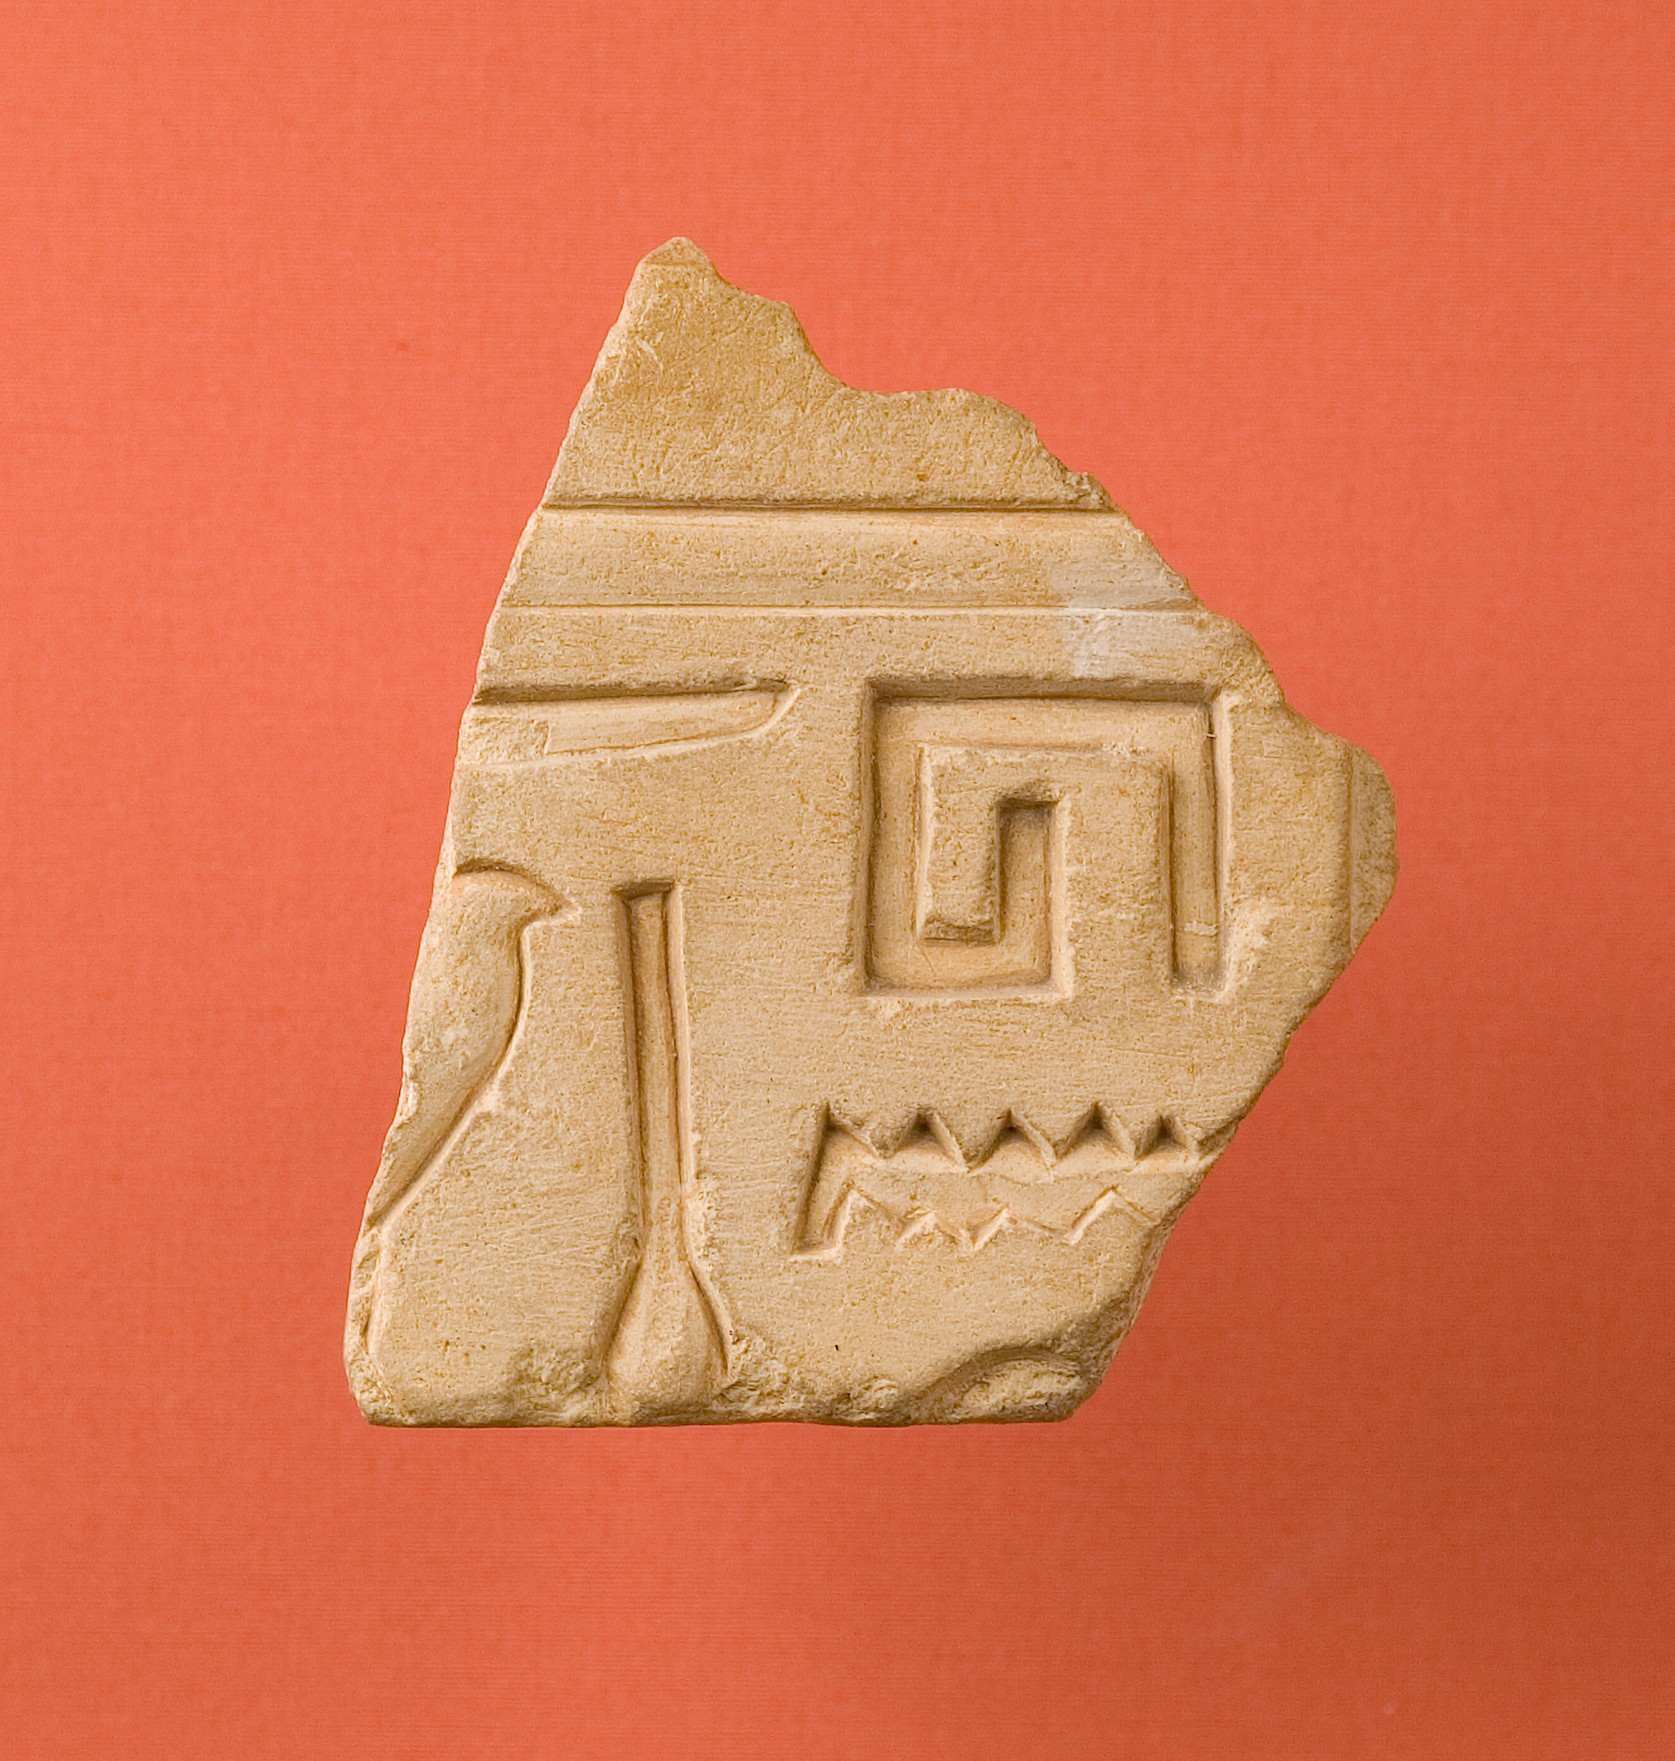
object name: relief, nebhepetre mentuhotep's wife, shrine fragment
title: Relief, Nebhepetre Mentuhotep's wives, shrine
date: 2051-2030 BCE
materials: limestone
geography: egypt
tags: hieroglyphs